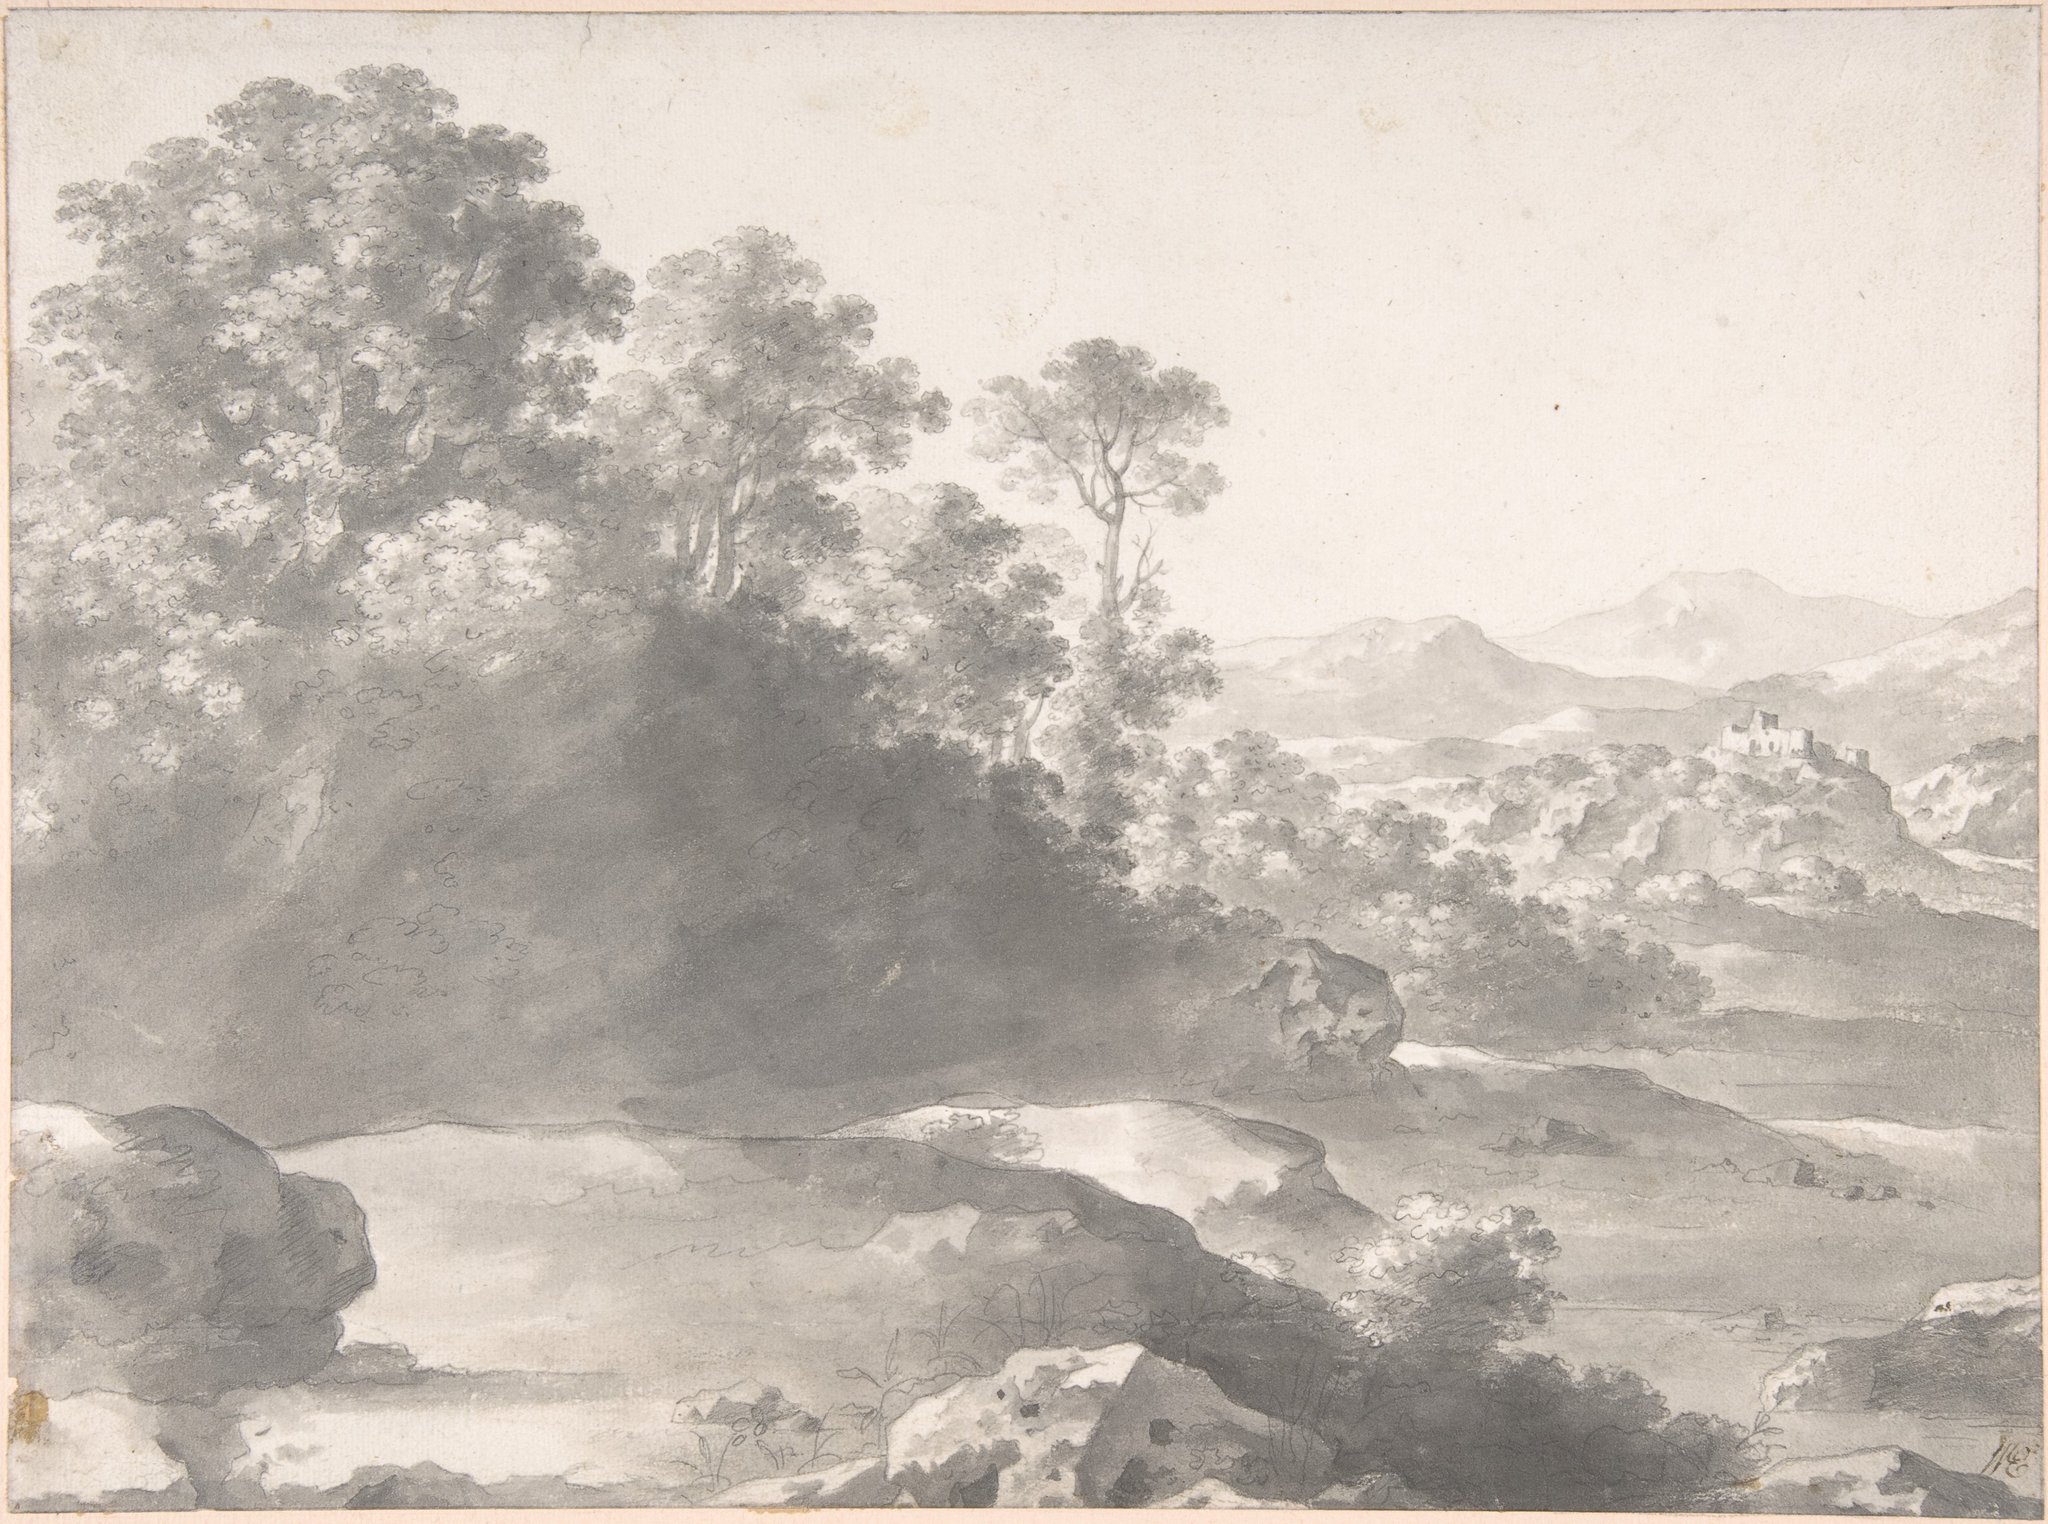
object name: drawing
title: Landscape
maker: cornelis van poelenburch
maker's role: artist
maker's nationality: dutch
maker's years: 1594-1667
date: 1609-1667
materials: chalk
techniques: brush, wash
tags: hills,landscapes,trees